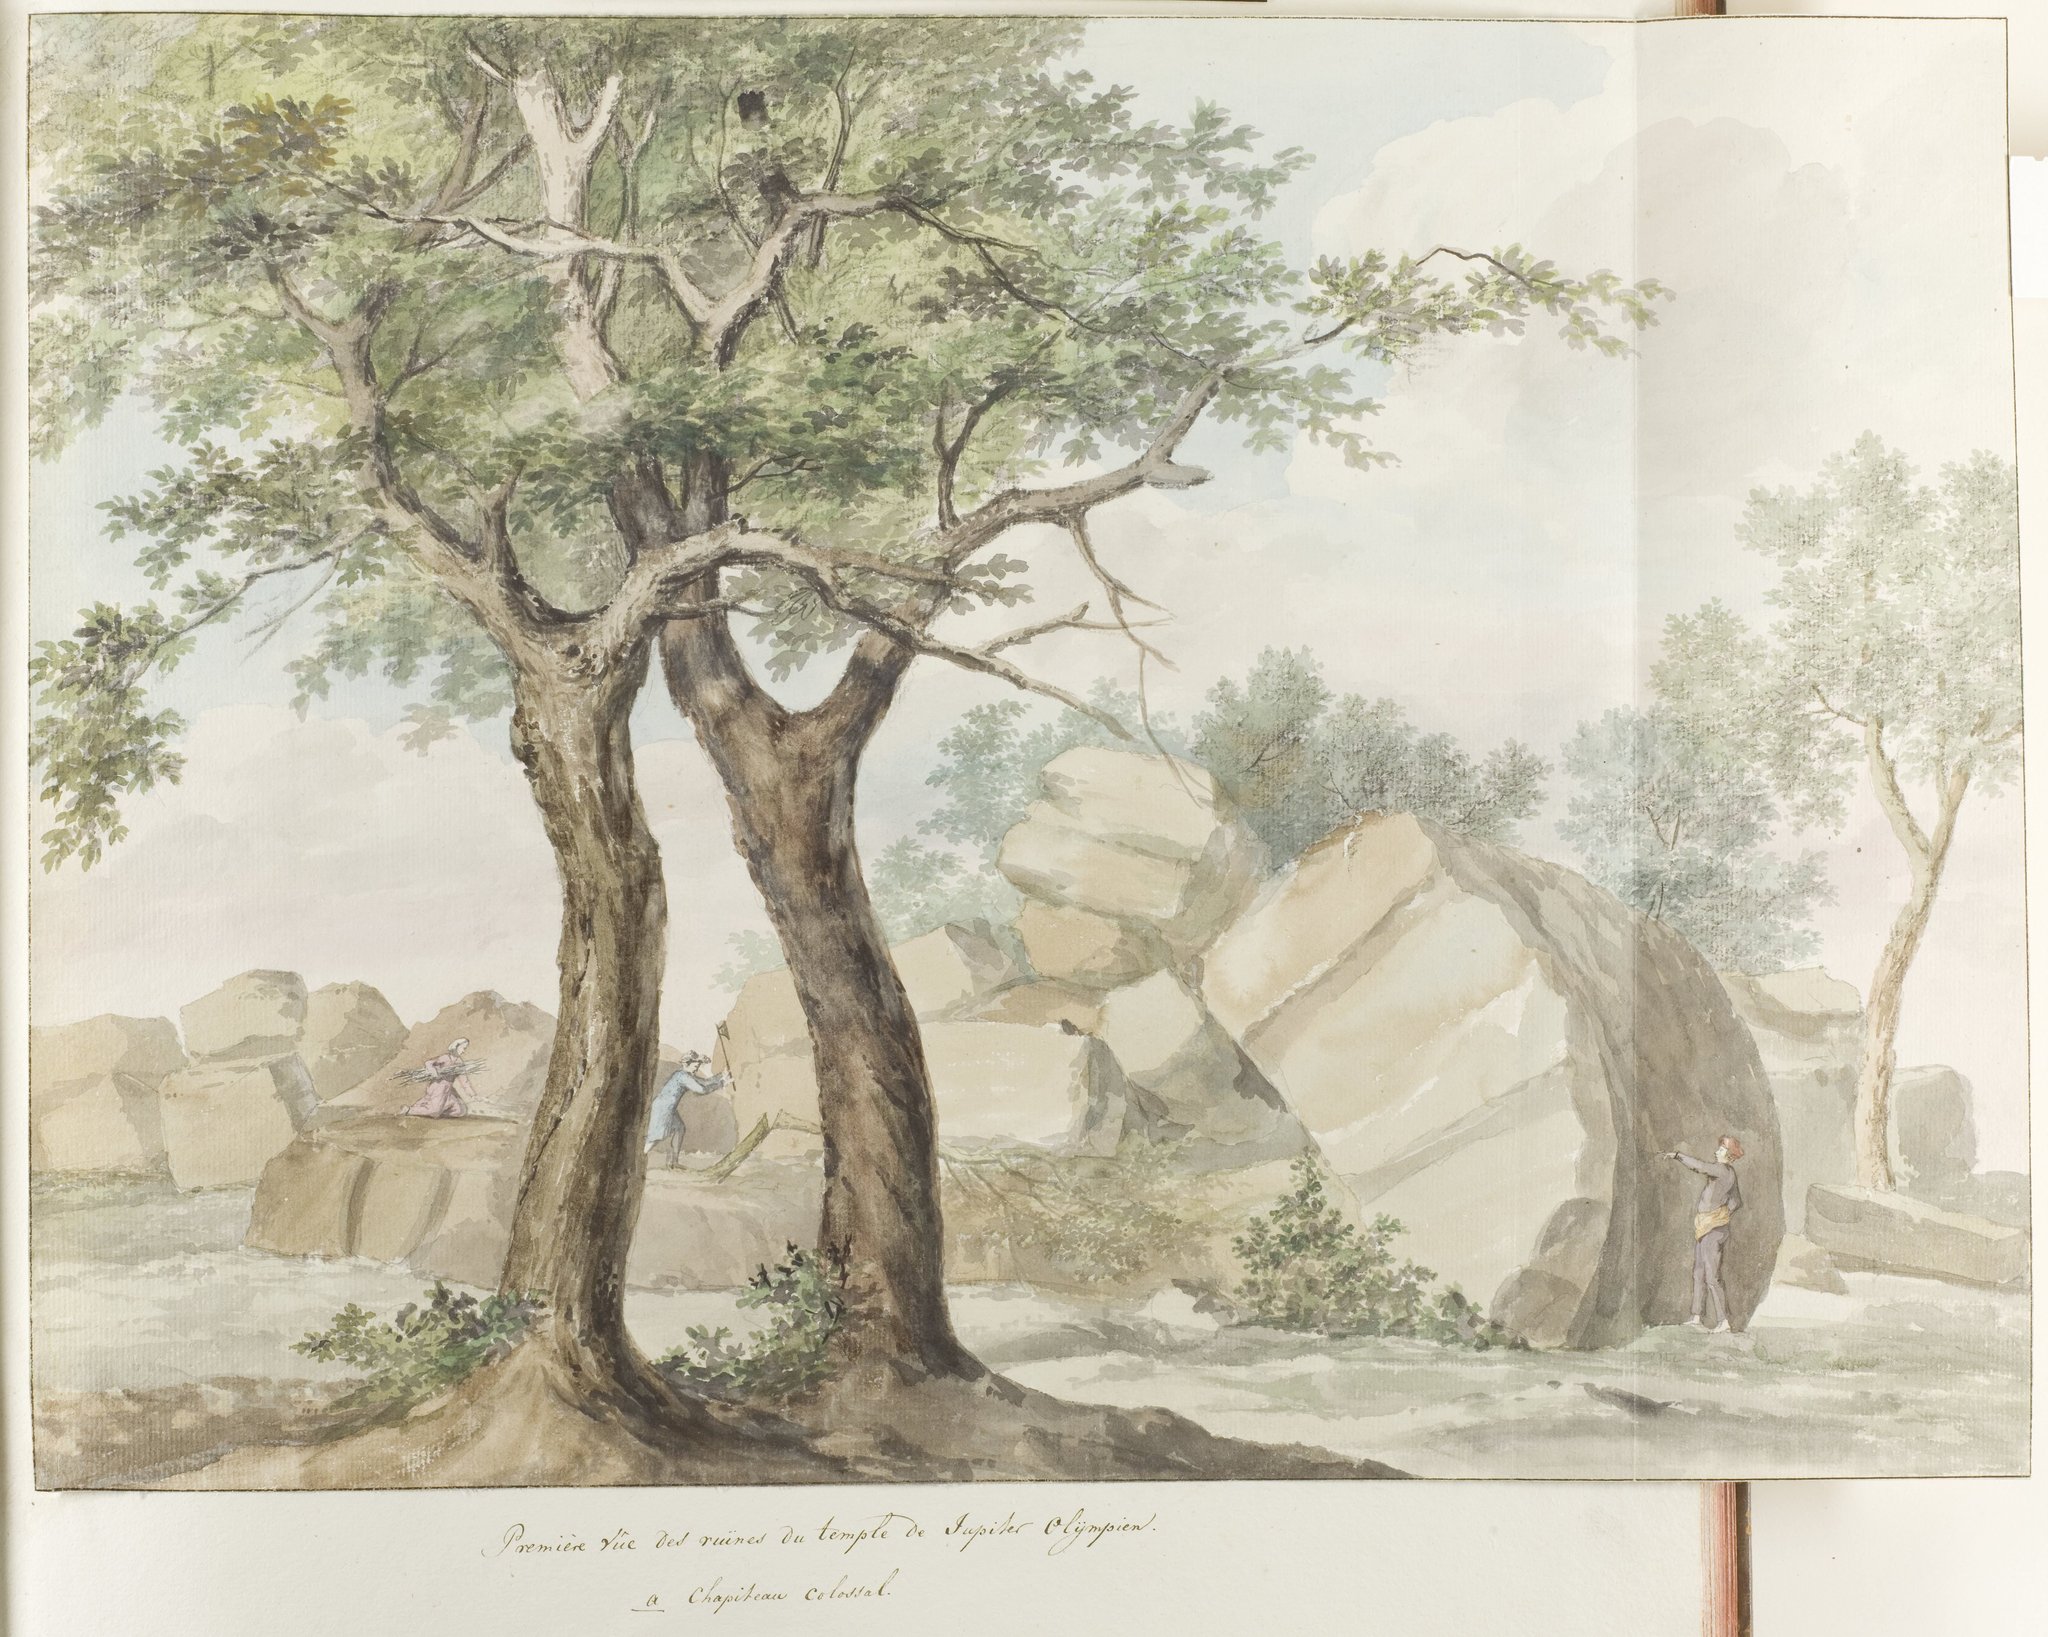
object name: watercolor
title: Ruïne van Zeus Olympus tempel in oude Agrigento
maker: louis ducros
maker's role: draughtsman, print maker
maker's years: 1748-1810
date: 1778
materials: chalk, paper, watercolor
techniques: brush, pen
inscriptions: inscription: ‘No 249 Première Vue des ruïnes du templede Jupiter Olympien’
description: Tekening uit het album 'Voyage en Italie, en Sicile et à Malte', 1778.